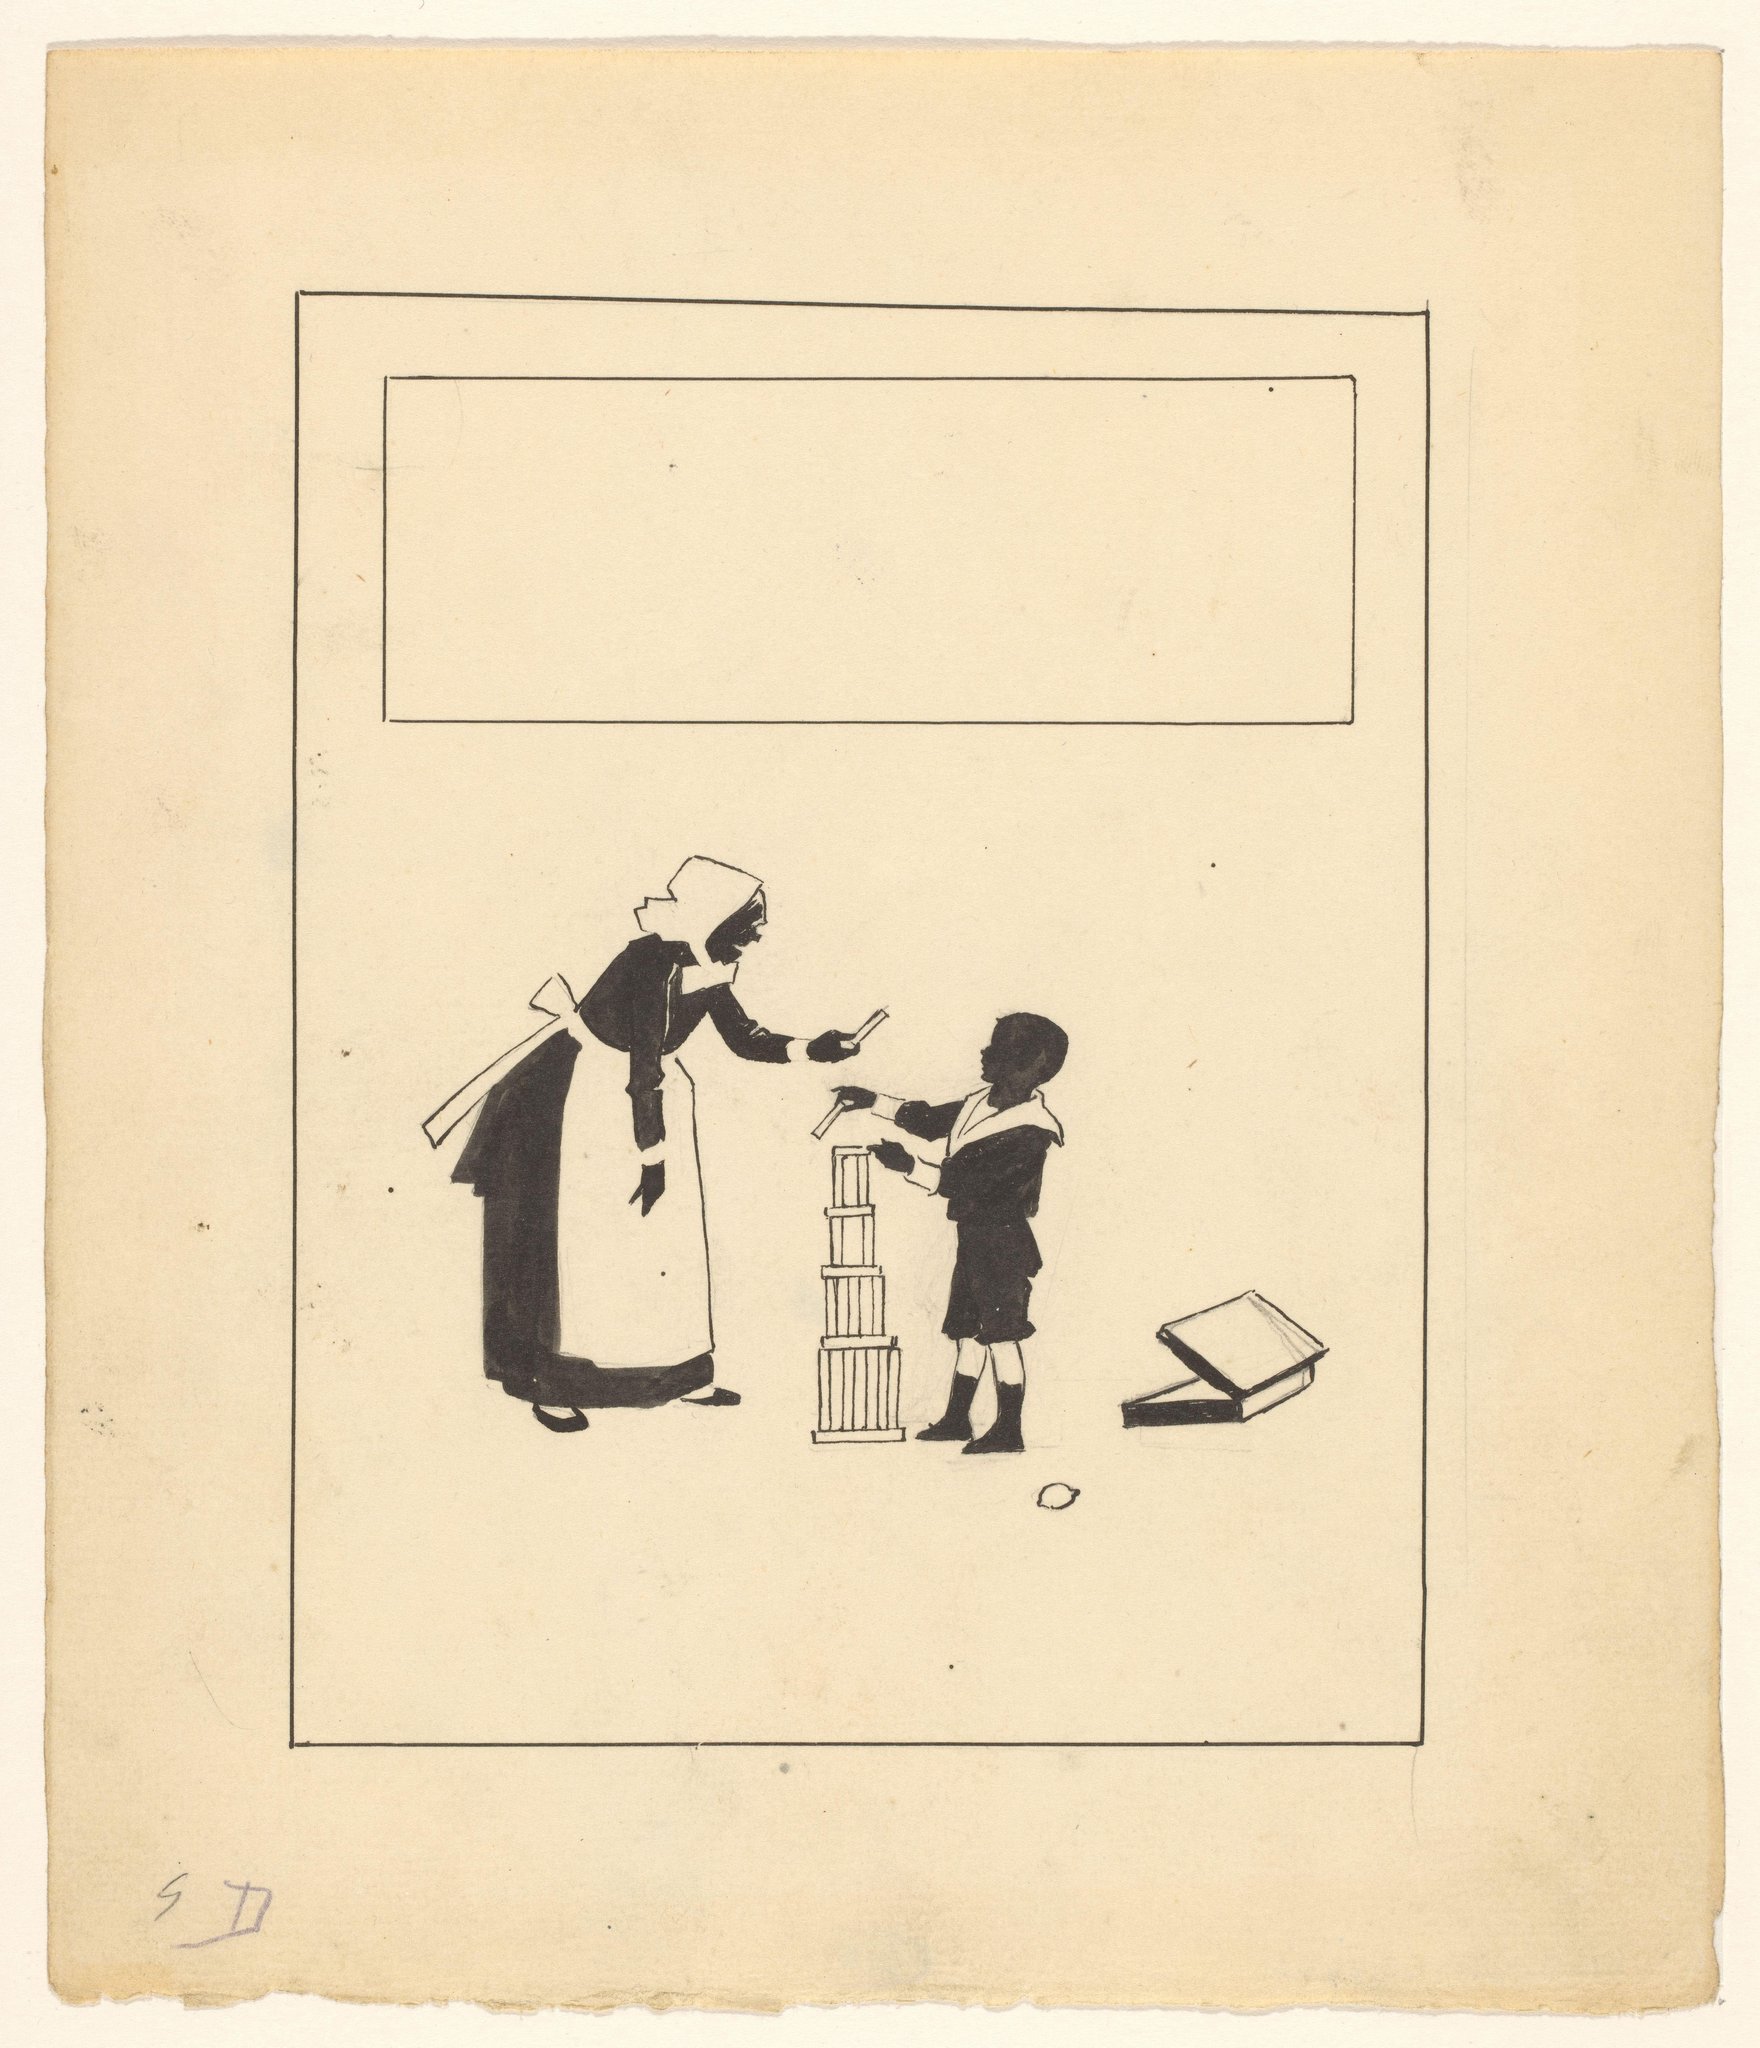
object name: boekillustratie ontwerp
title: Vrouw en jongen bouwen een blokkentoren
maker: Anonymous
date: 1880-1910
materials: ink, paper, pencil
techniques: brush, pen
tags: (playing with) blocks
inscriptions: collector's mark: Lugt 2228a, number: ‘4 II’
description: Een vrouw en jongen staan met blokken in de hand bij een blokkentoren. Op de grond liggen een doos en stuk fruit.